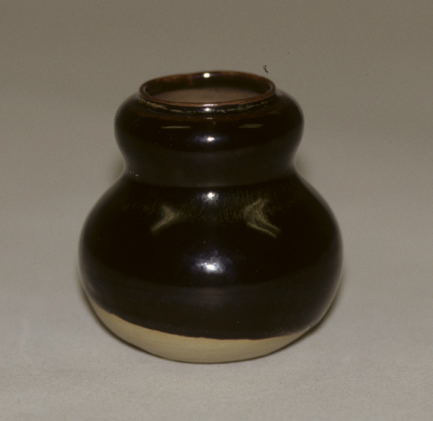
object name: tea jar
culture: japanese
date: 1650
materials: glaze, paste